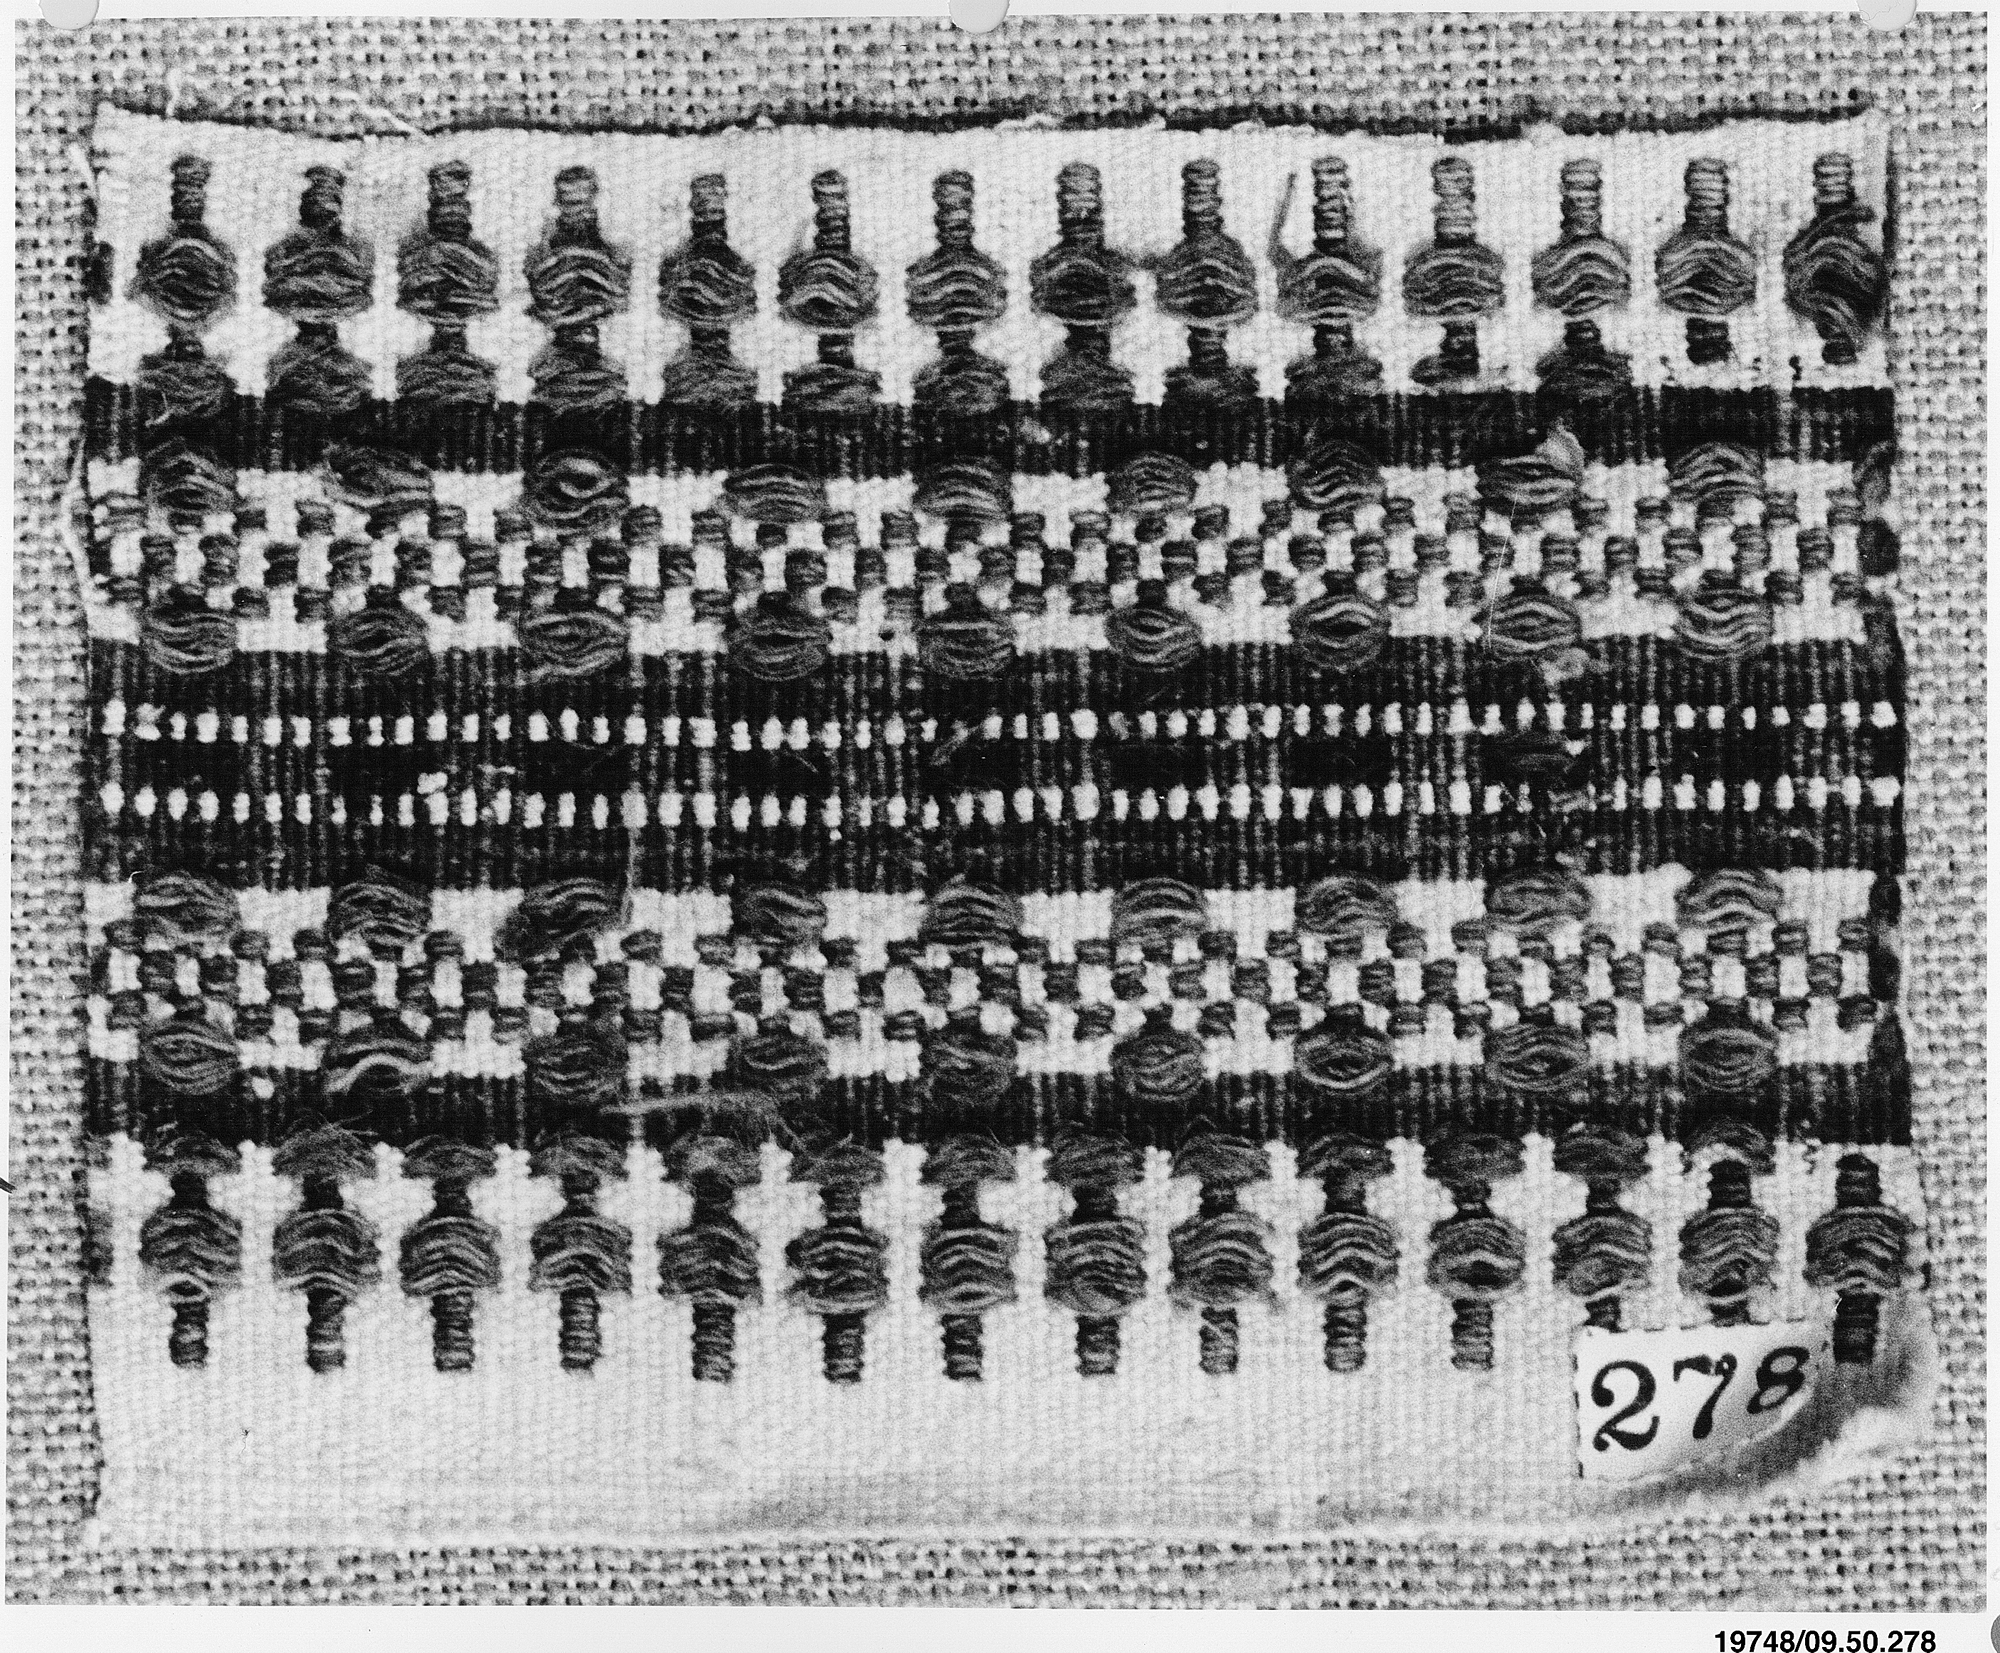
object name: band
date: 1701-1800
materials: linen, wool